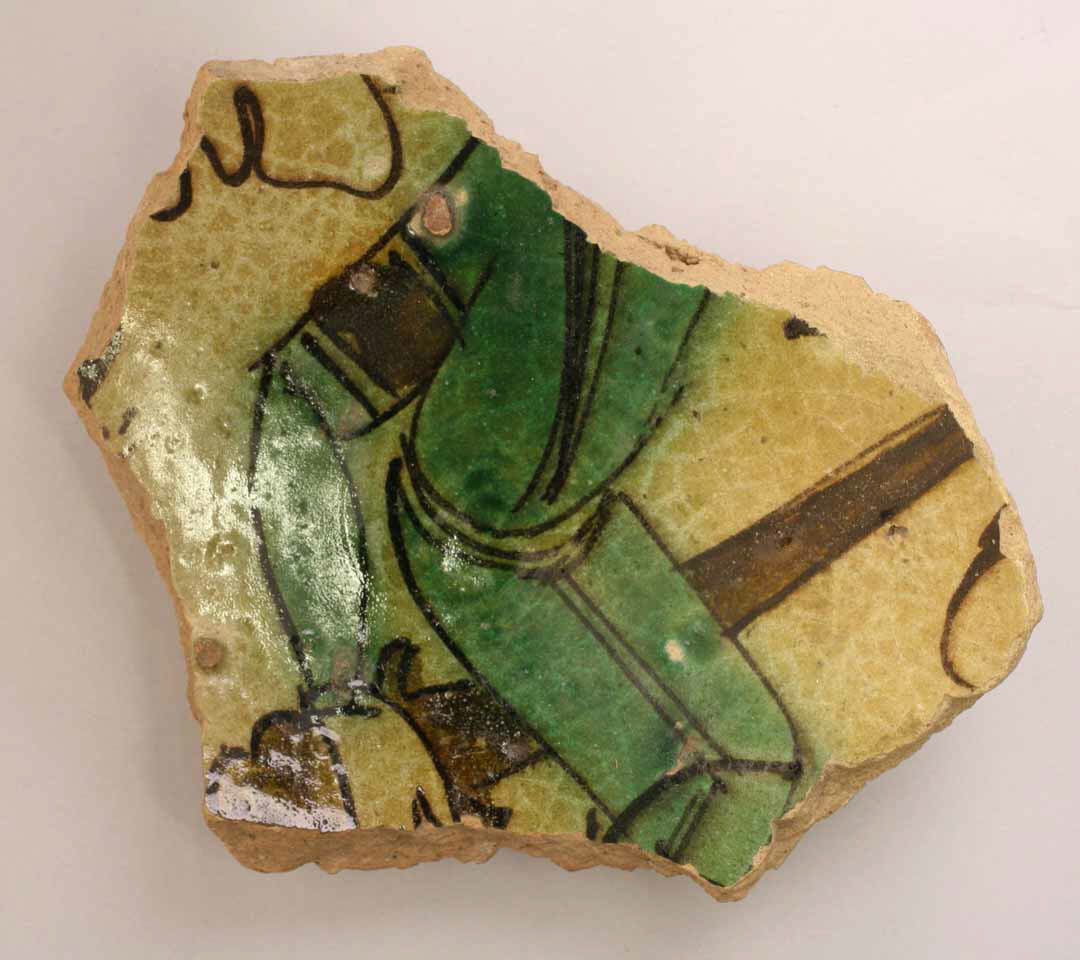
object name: fragment of a bowl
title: Fragment of a Bowl with a Figure Holding a Sword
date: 901-1200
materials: earthenware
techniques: glazing, incising, polychrome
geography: egypt